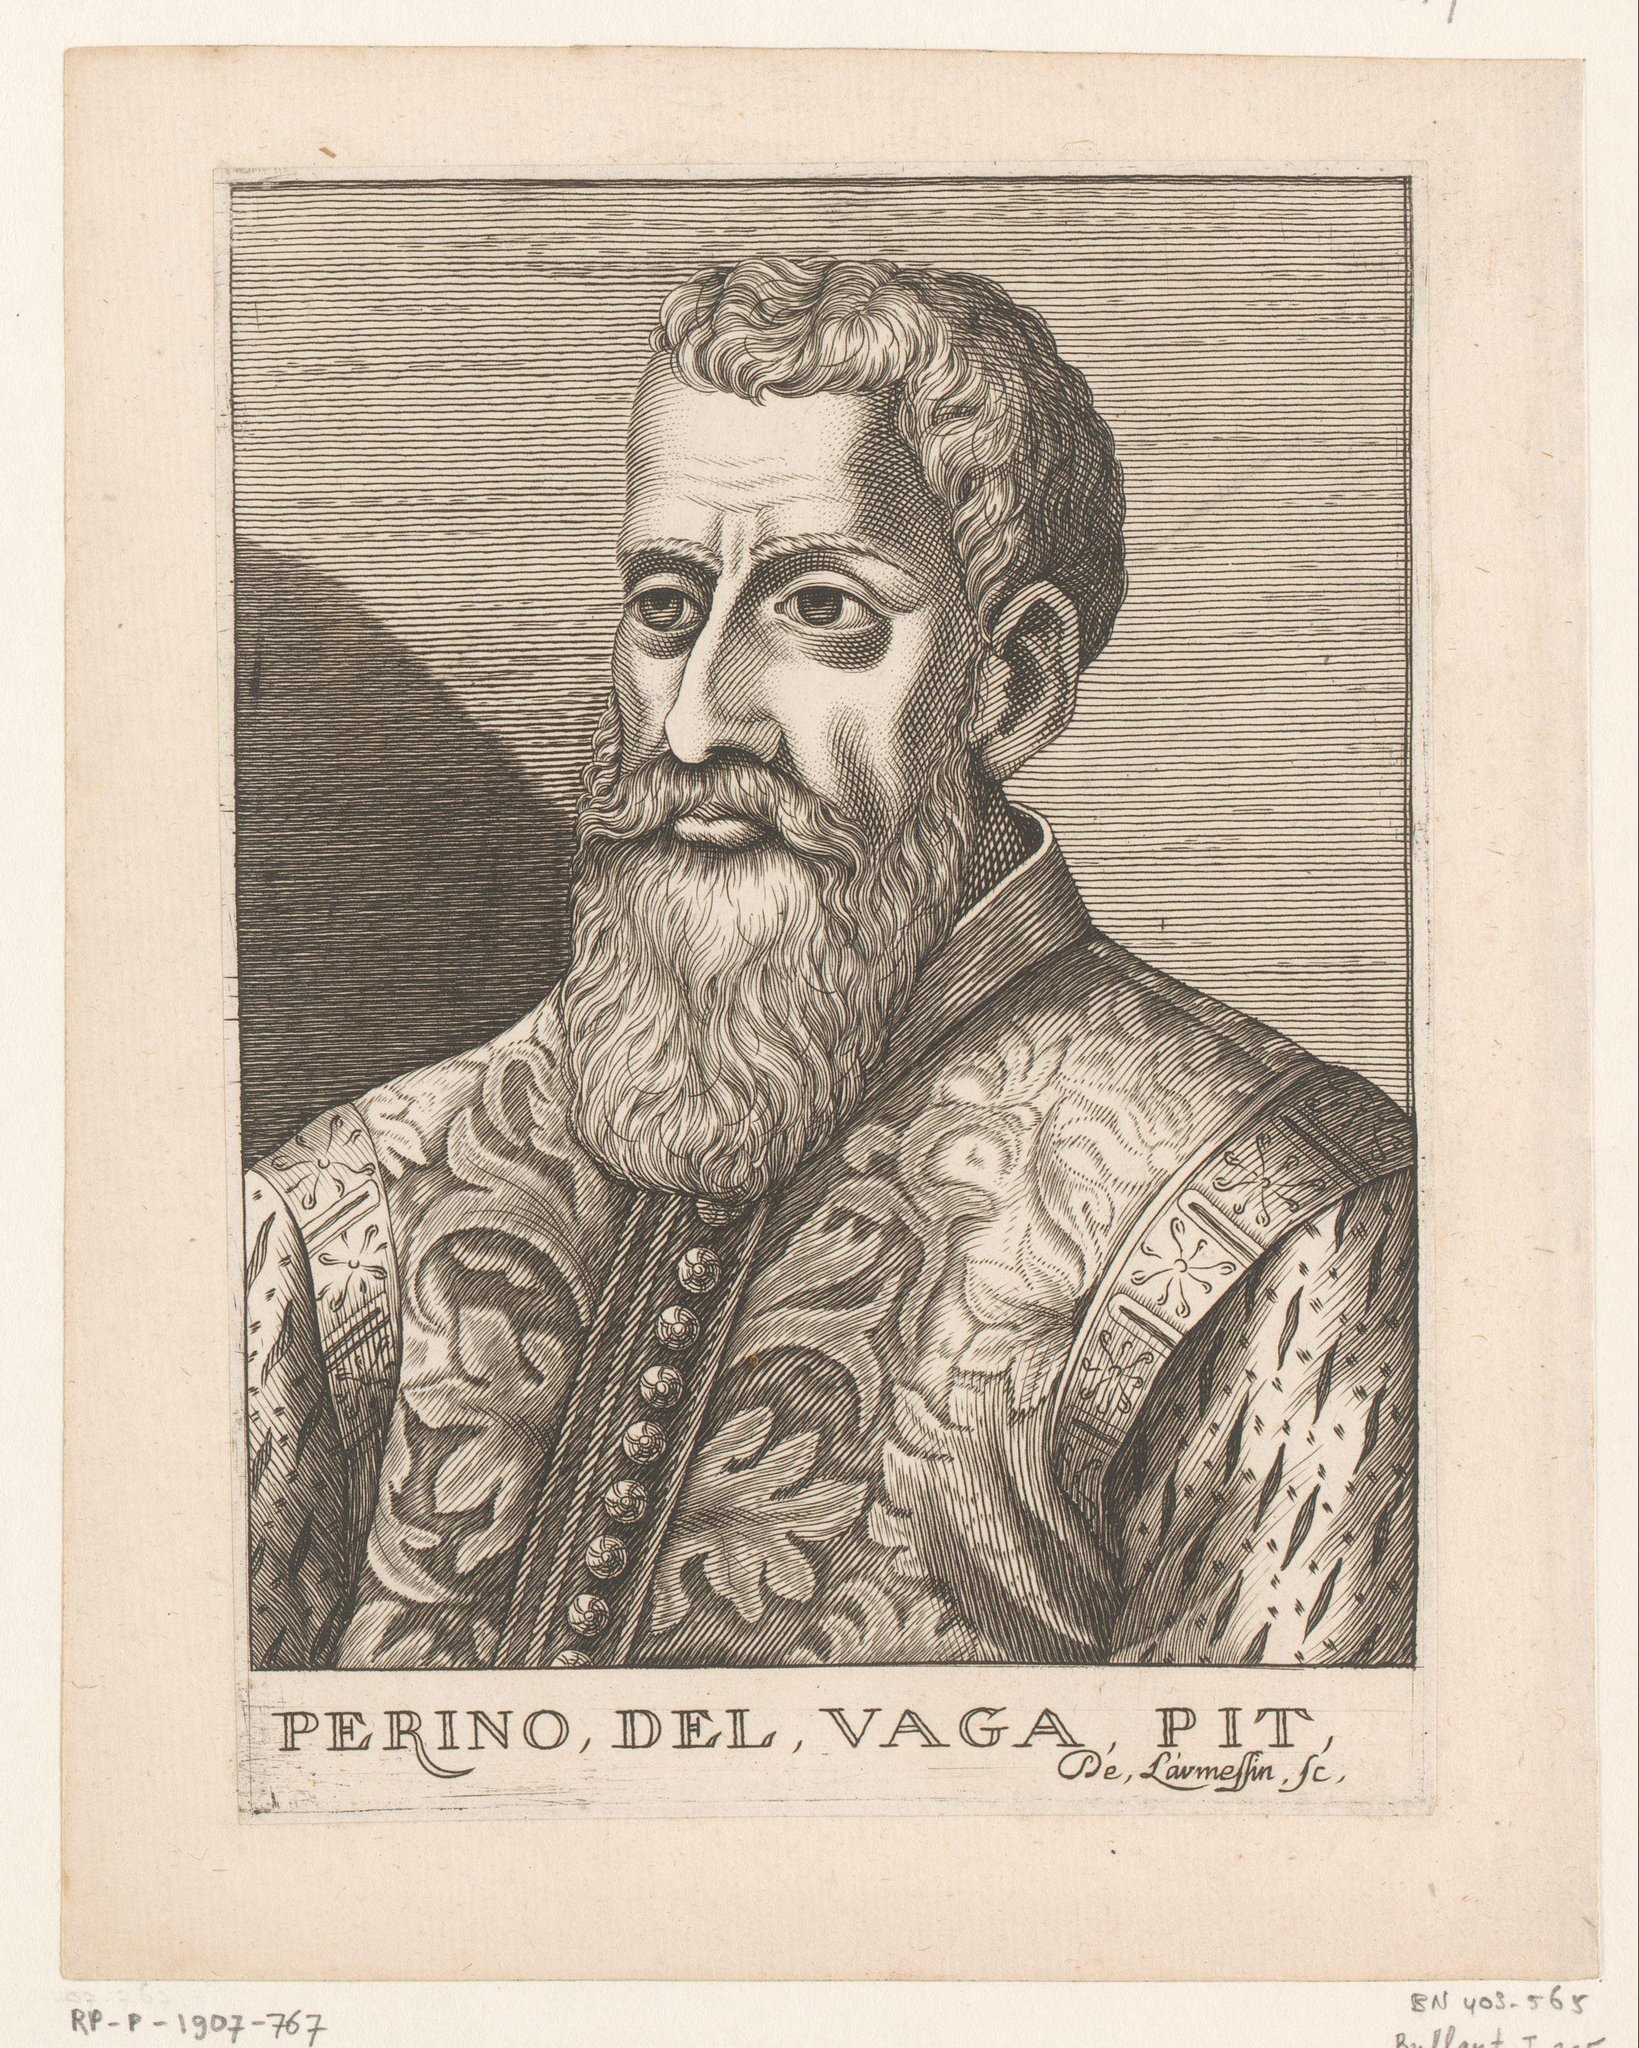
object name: print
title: Portret van Periono del Vaga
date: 1682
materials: paper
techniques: engraving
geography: brussels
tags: rome, painter, draughtsman, perino del vaga, historical persons, portrait, self-portrait of artist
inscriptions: collector's mark: Lugt 2228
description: Prent gebruikt voor: Bullart, Isaac. Académie des Sciences et Arts contenant les vies et éloges his. des hommes illustres qui ont excellé en ces professions depuis environ quatre siècles. Brussel: François Foppens, 1682. Het boek werd in 1682 eveneens in Amsterdam uitgegeven door de erfgenamen van Daniel Elzevier. Ieder portret betreft een illustratie bij de biografie van een kunstenaar of geleerde. De meeste portretten werden door Nicolas de Larmessin vervaardigd (162), 93 door De Boulonois en een derde door ongeïdentificeerde prentmakers. Dit betreft een illustratie op p. 395, deel II.